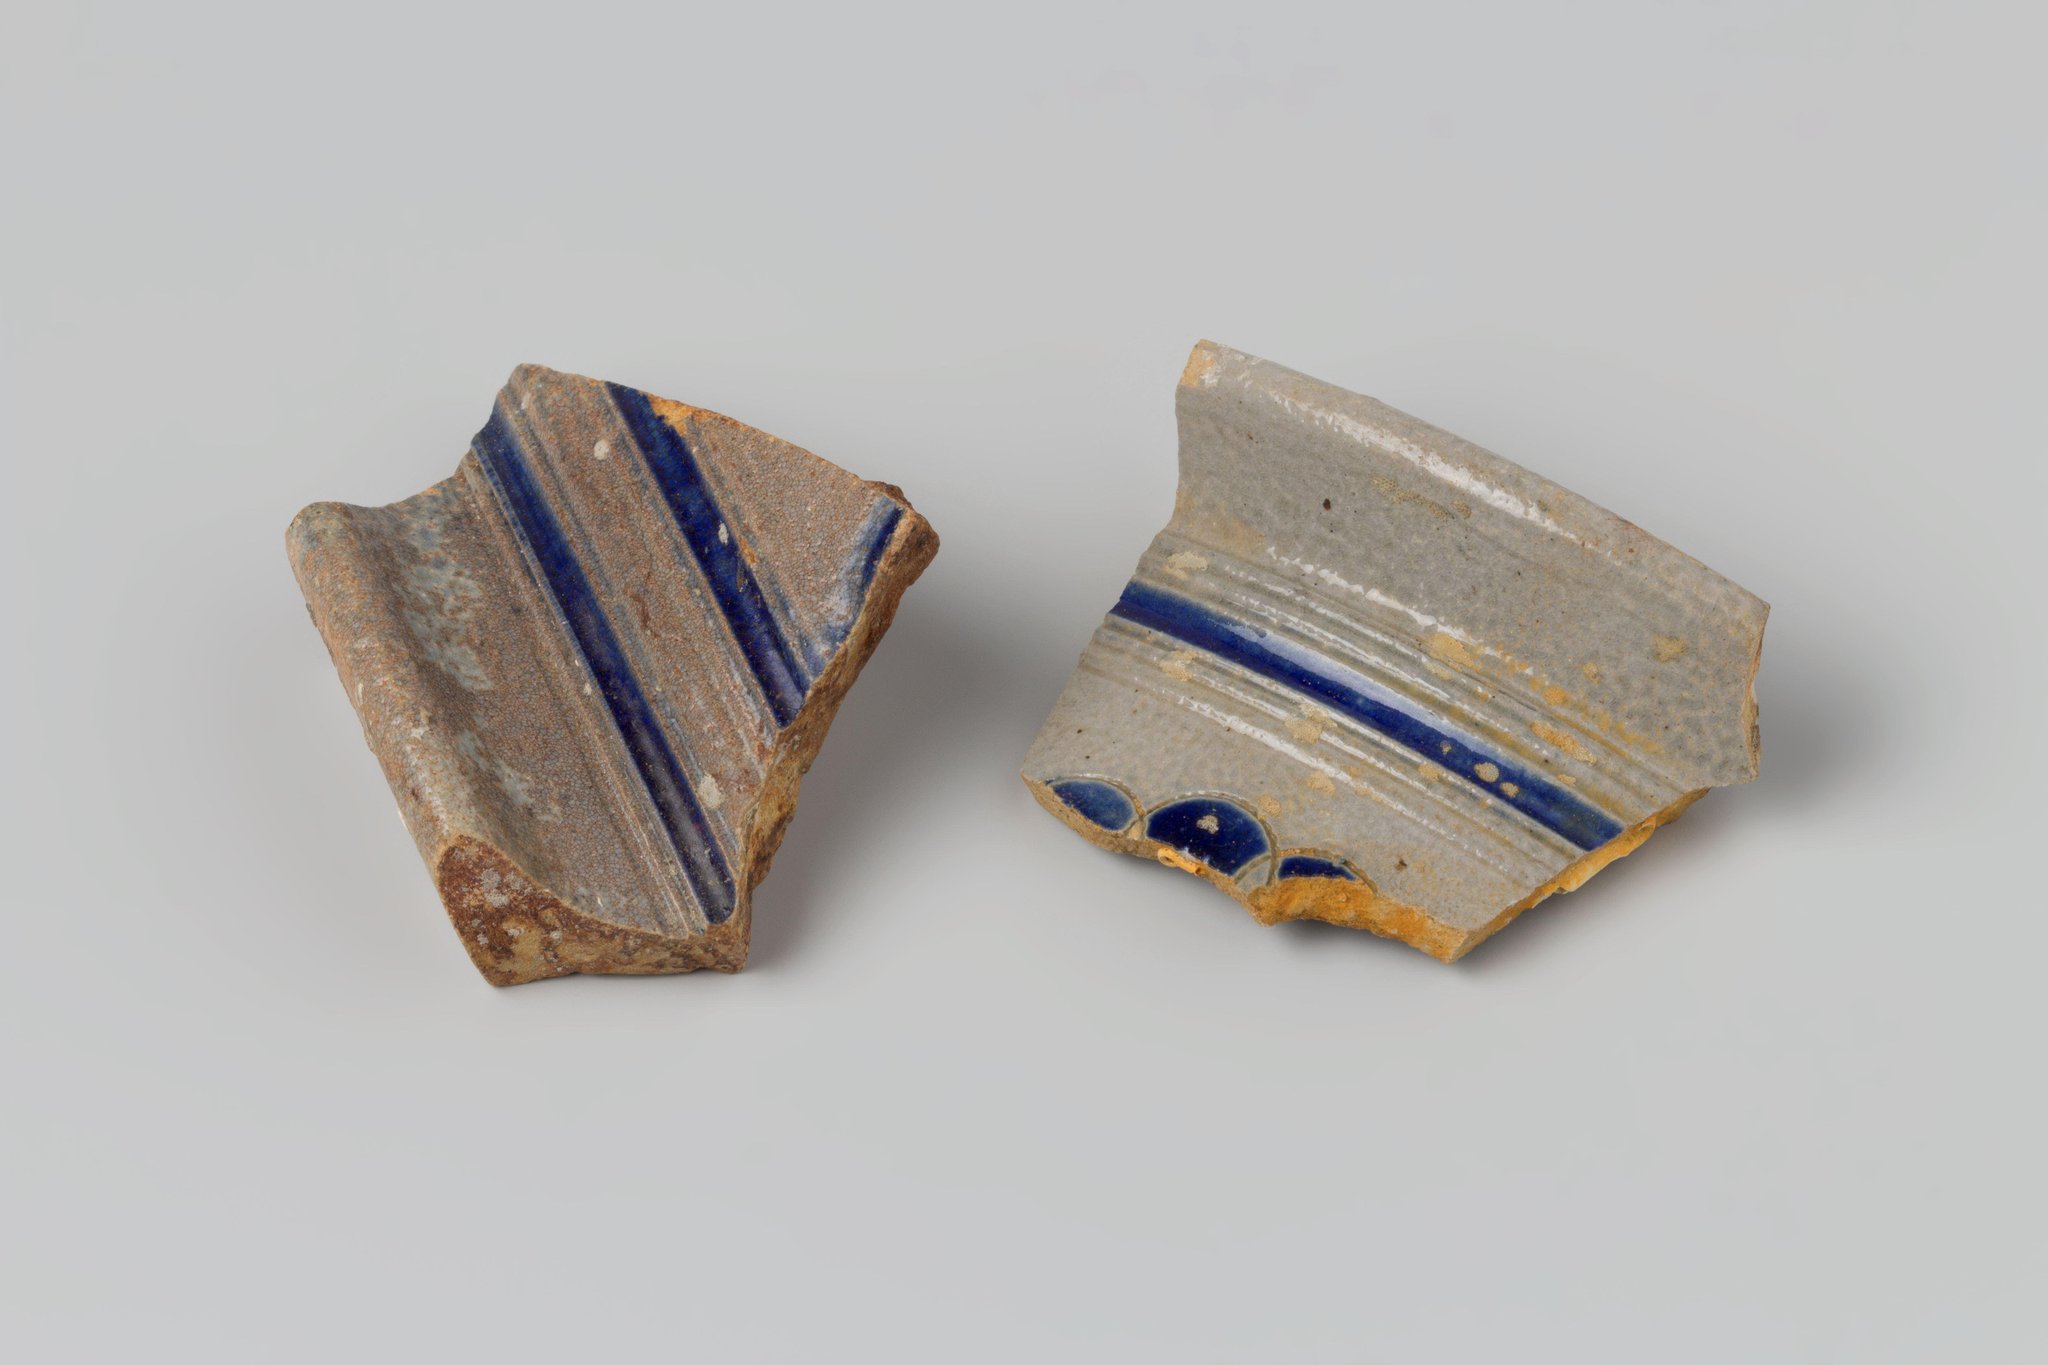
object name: pot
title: Randfragmenten van potten uit het wrak van de Oost-Indiëvaarder Hollandia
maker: Anonymous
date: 1700-1743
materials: stoneware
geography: westerwald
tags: verenigde oostindische compagnie, hollandia (schip), annet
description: Stoneware, Rhenish, Westerwald, pot; fragm of rims, sim. NG 1980-27H2624r.